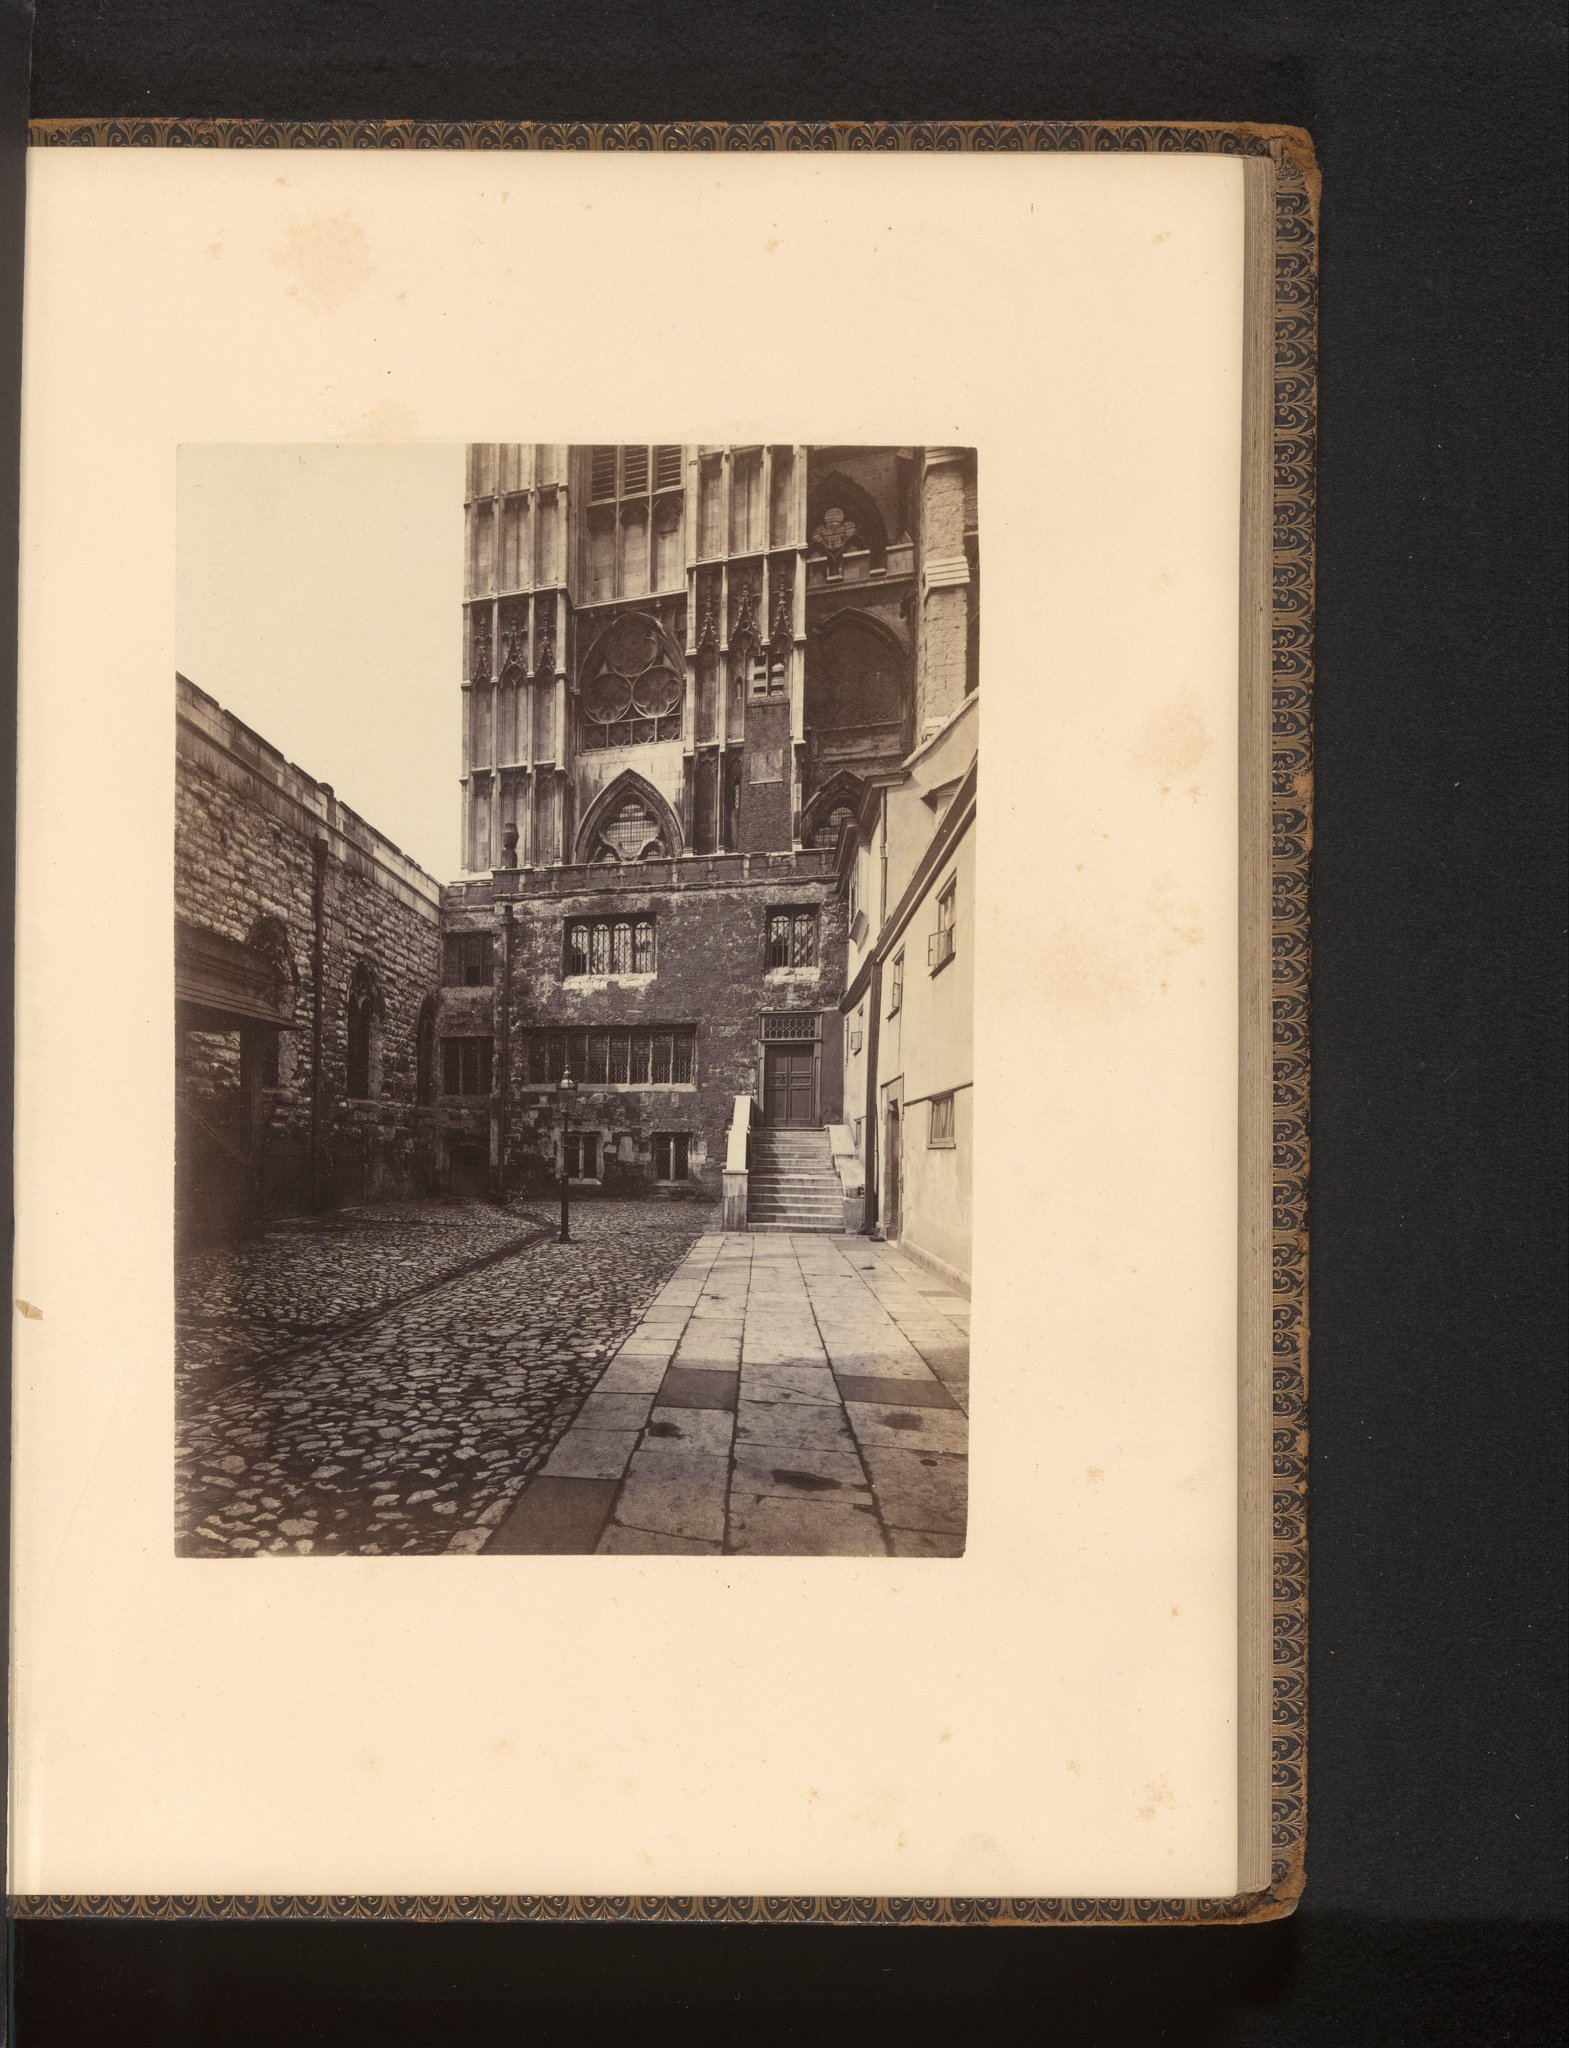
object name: page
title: Gezicht op Westminster Abbey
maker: john harrington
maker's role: fotograaf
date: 1864-1869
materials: photographic support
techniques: albumen print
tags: abbey, monastery, convent ~ roman catholic church, church (exterior), westminster abbey